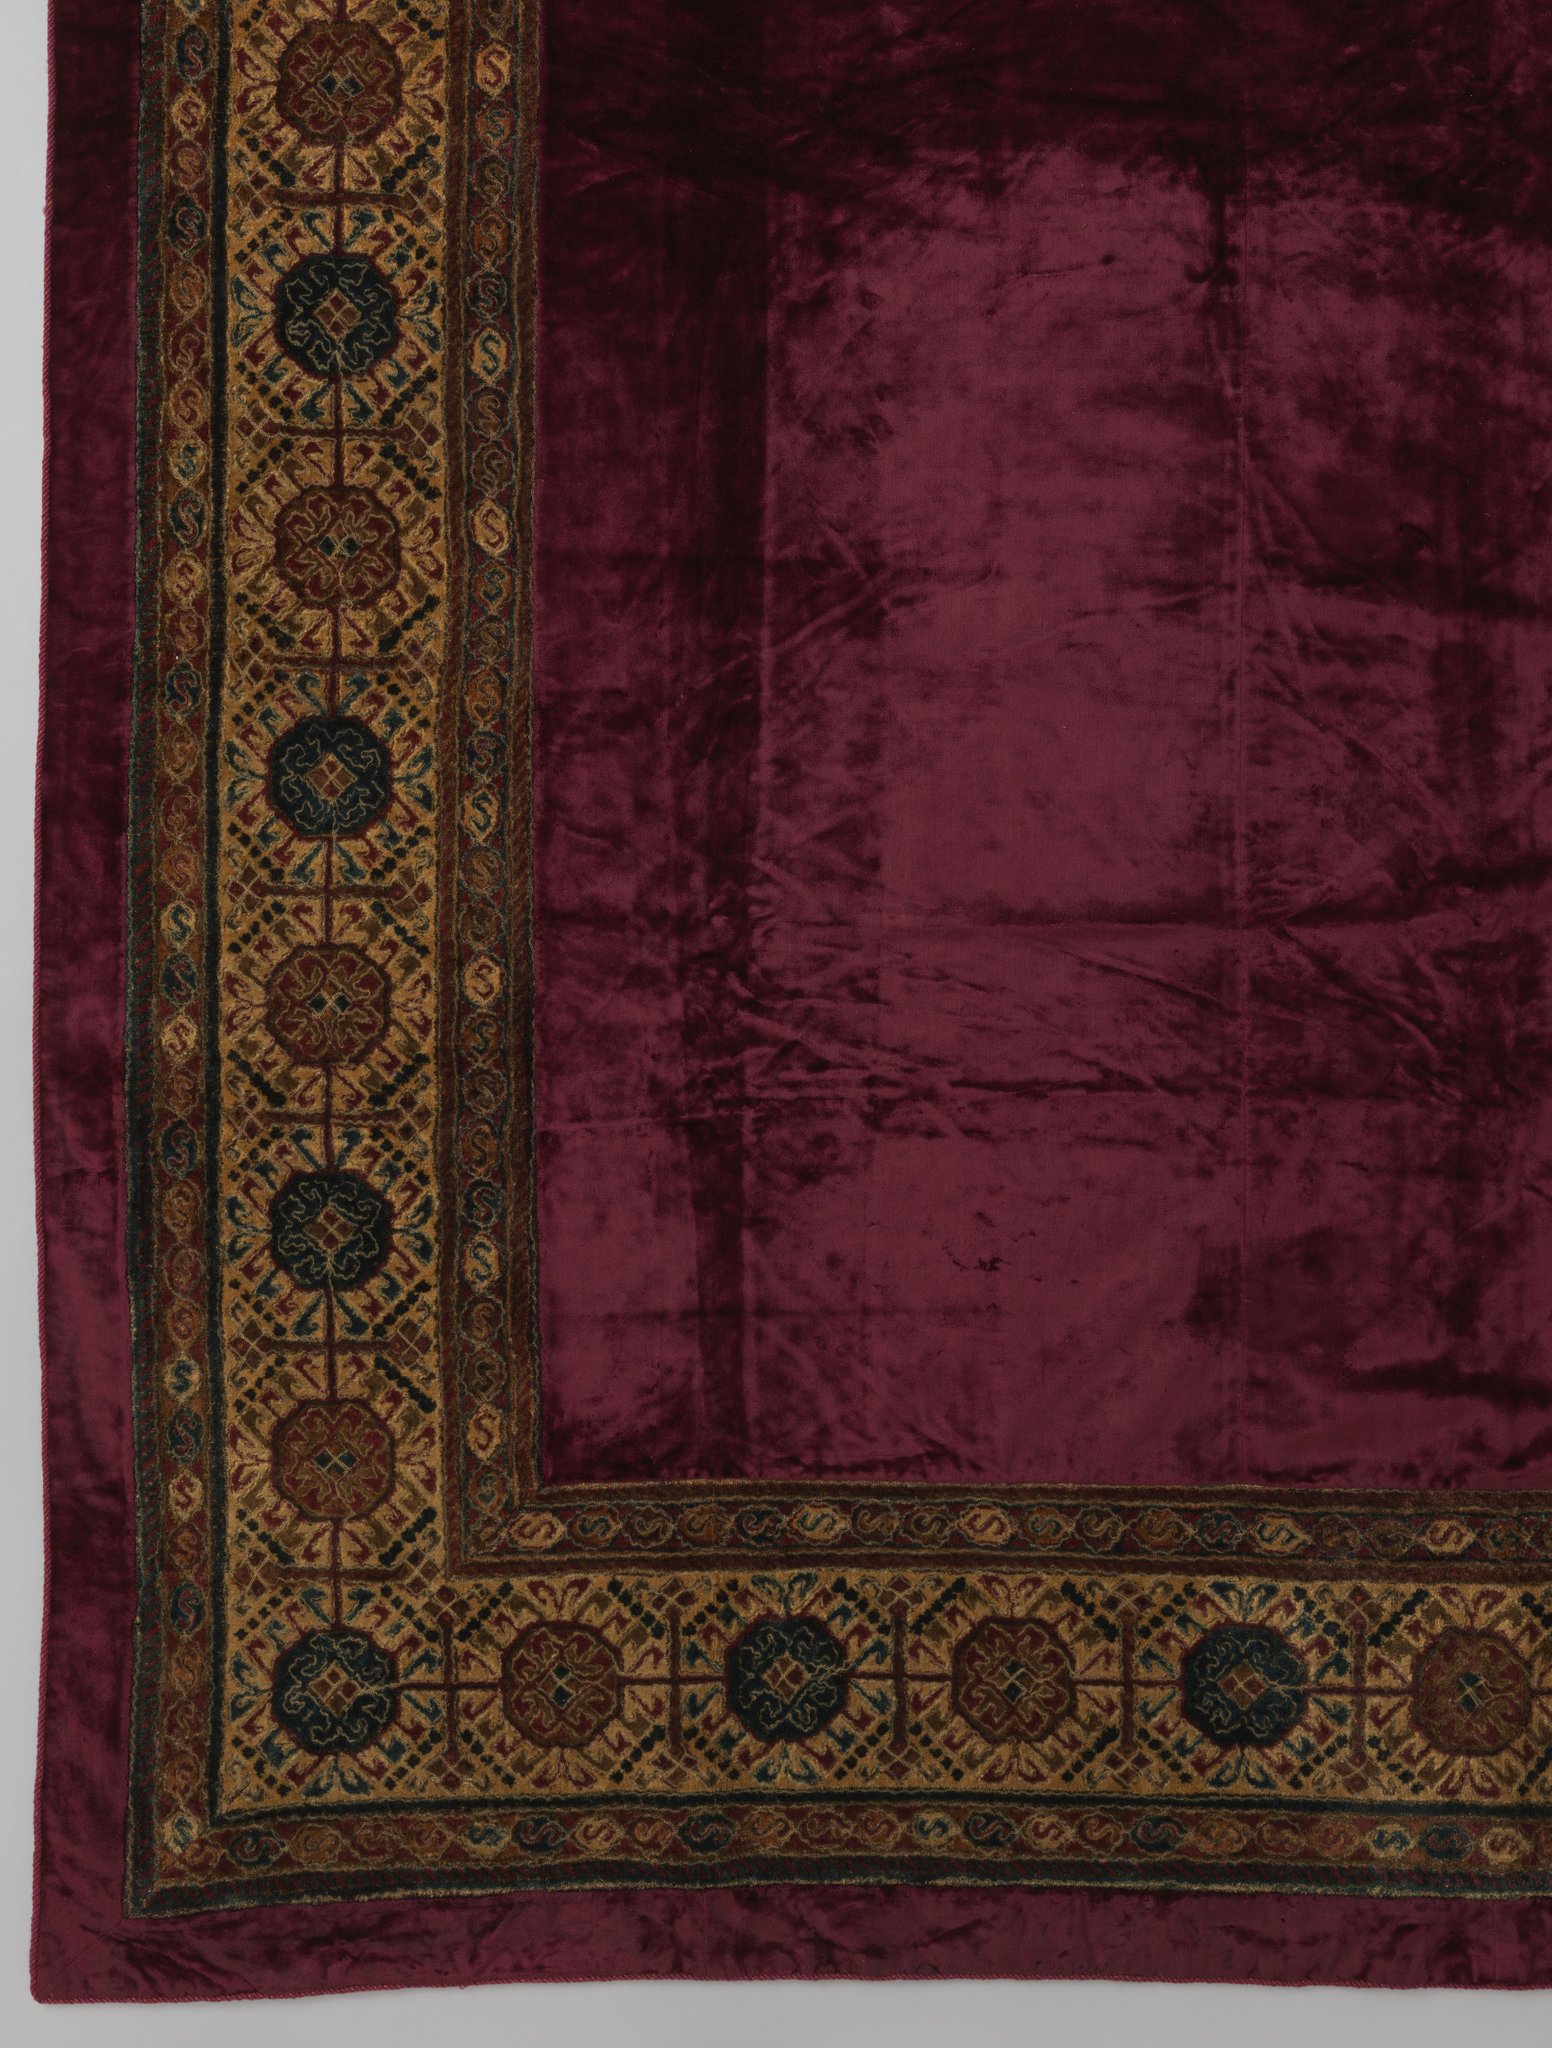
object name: interieuronderdeel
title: Gordijn van auberginekleurige velours, afgewerkt met breed galon van beige en veelkleurige velours met gouddraad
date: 1900-1925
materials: silk, velvet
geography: netherlands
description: Gordijn van auberginekleurige velours, afgewerkt met breed galon van beige en veelkleurige velours met gouddraad. Model: veloursbestaat uit twee banen met volle breedte en één smallere baan. Verticale aangenaaide sierrand met langsgenaaide reep velours. Langs onderzijde sierrand in de breedte. Voering: donker paarsrode satinet, afgewerkt met wijnrood sierkoord. Patroon: sierranden met motieven als Kaukasische tapijtrand, alle figuren met gouddraad omgeborduurd. Gemerkt op wit band: VOORSALON en BOK VOOR L.